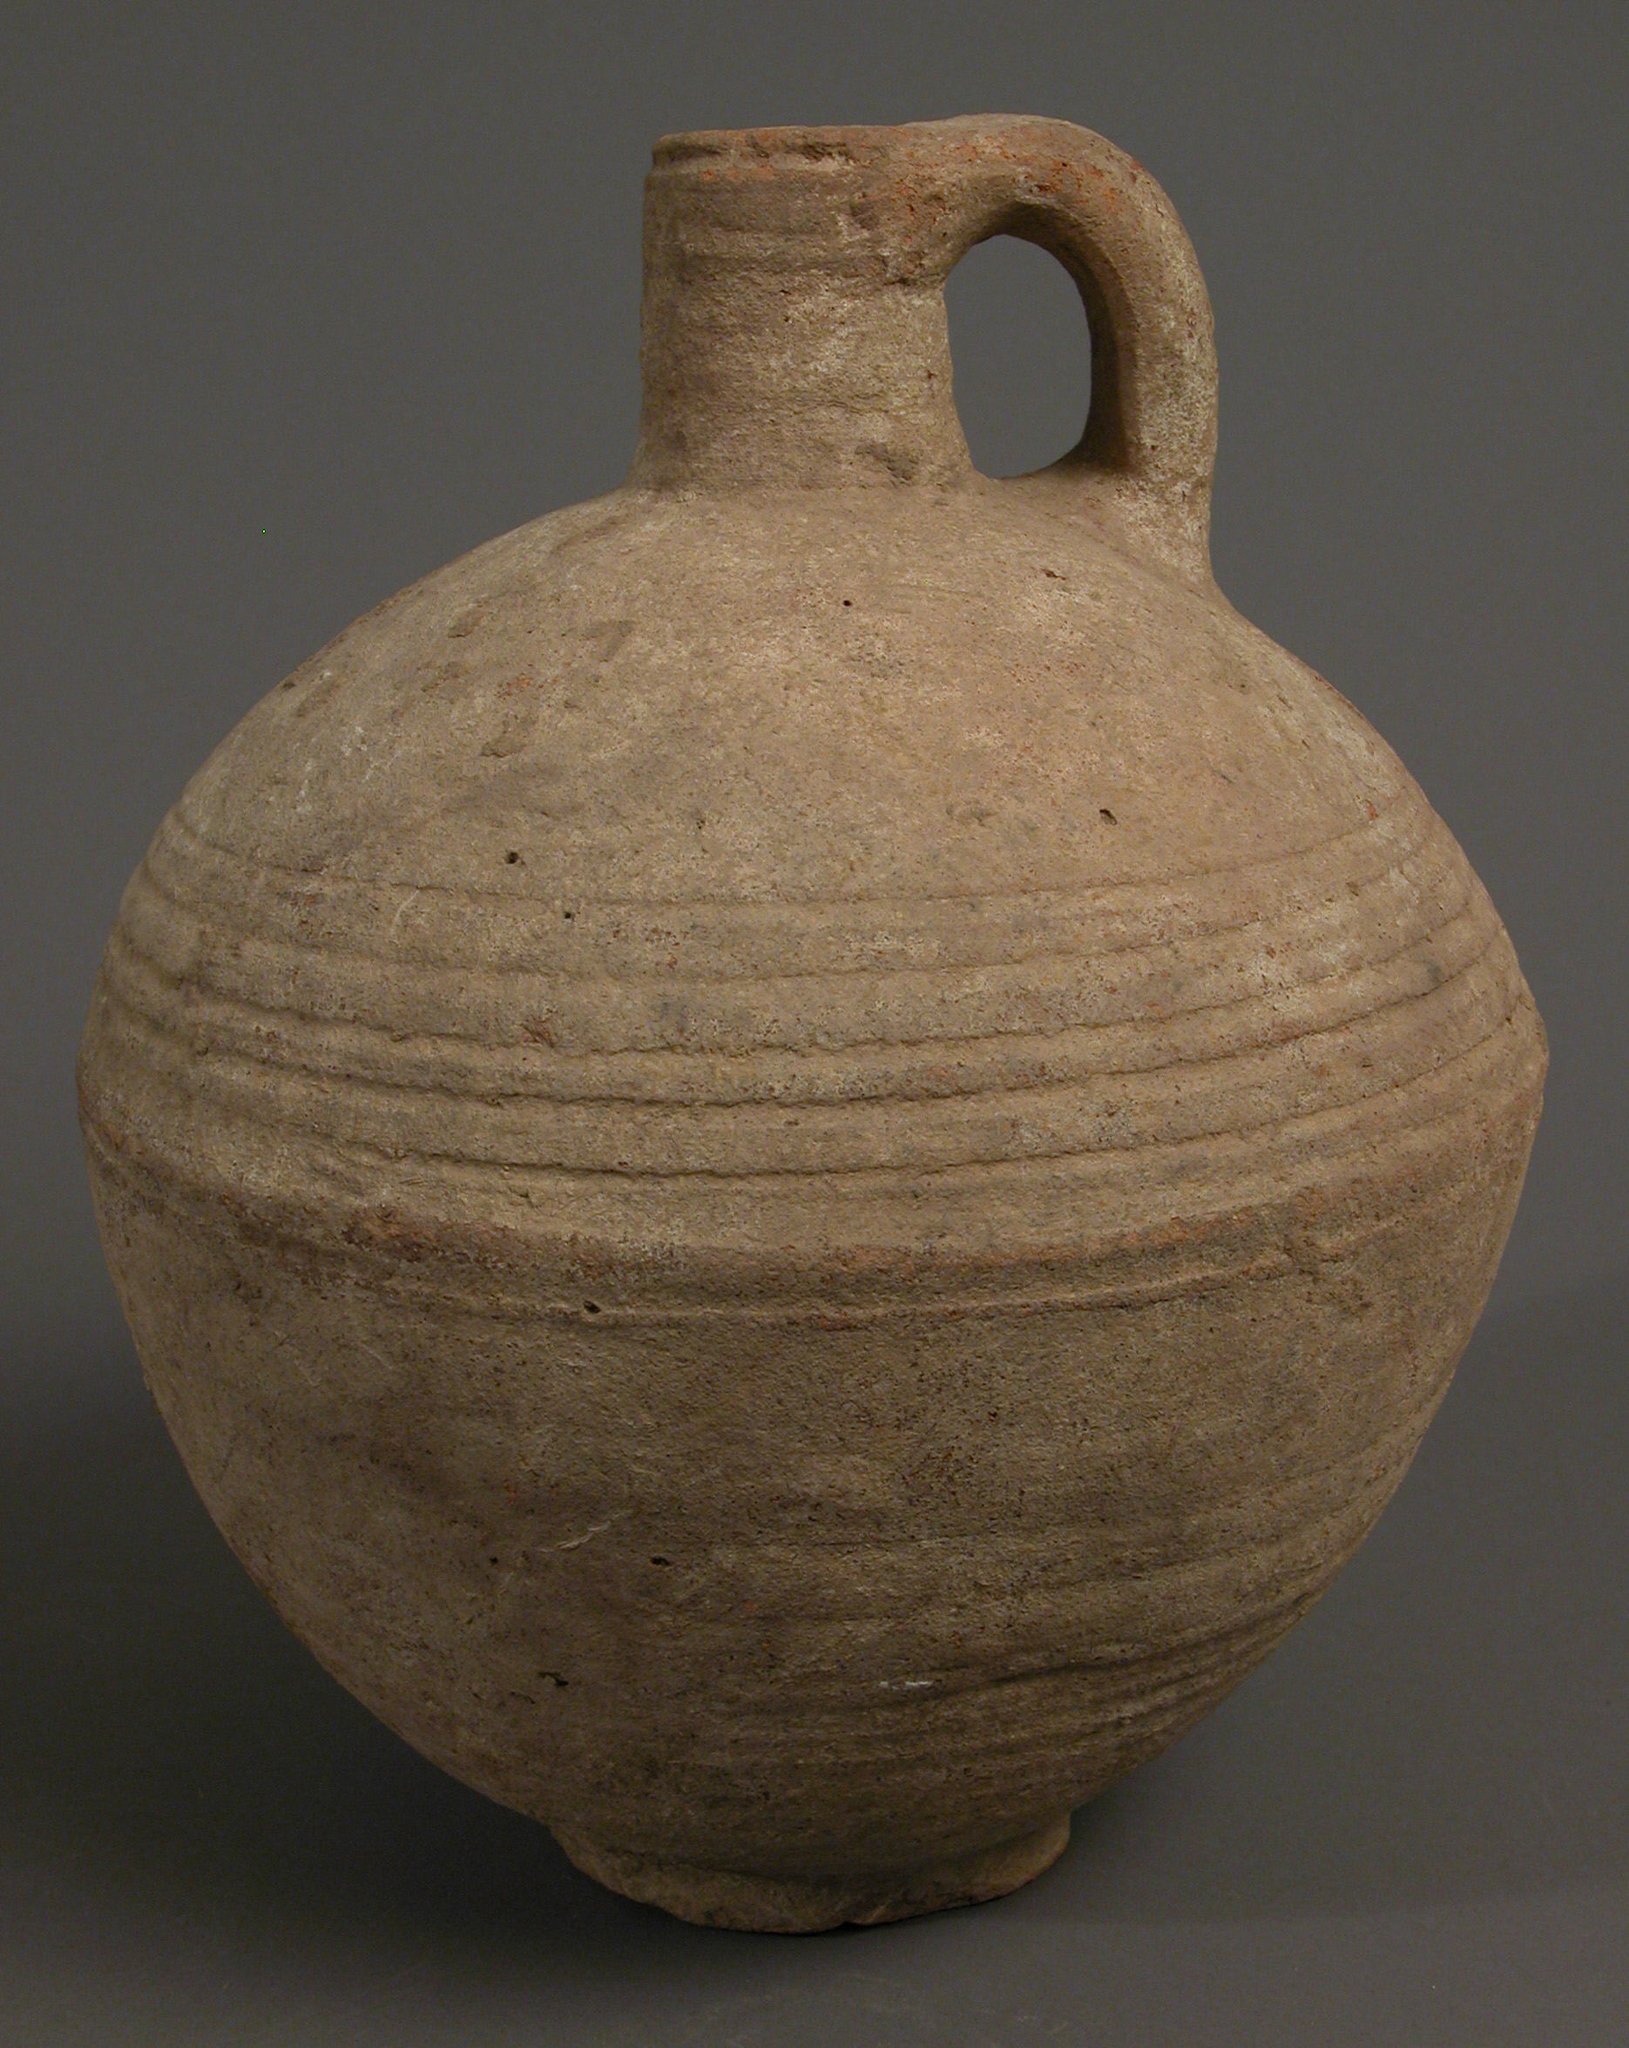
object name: jug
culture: coptic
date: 301-700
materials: earthenware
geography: egypt